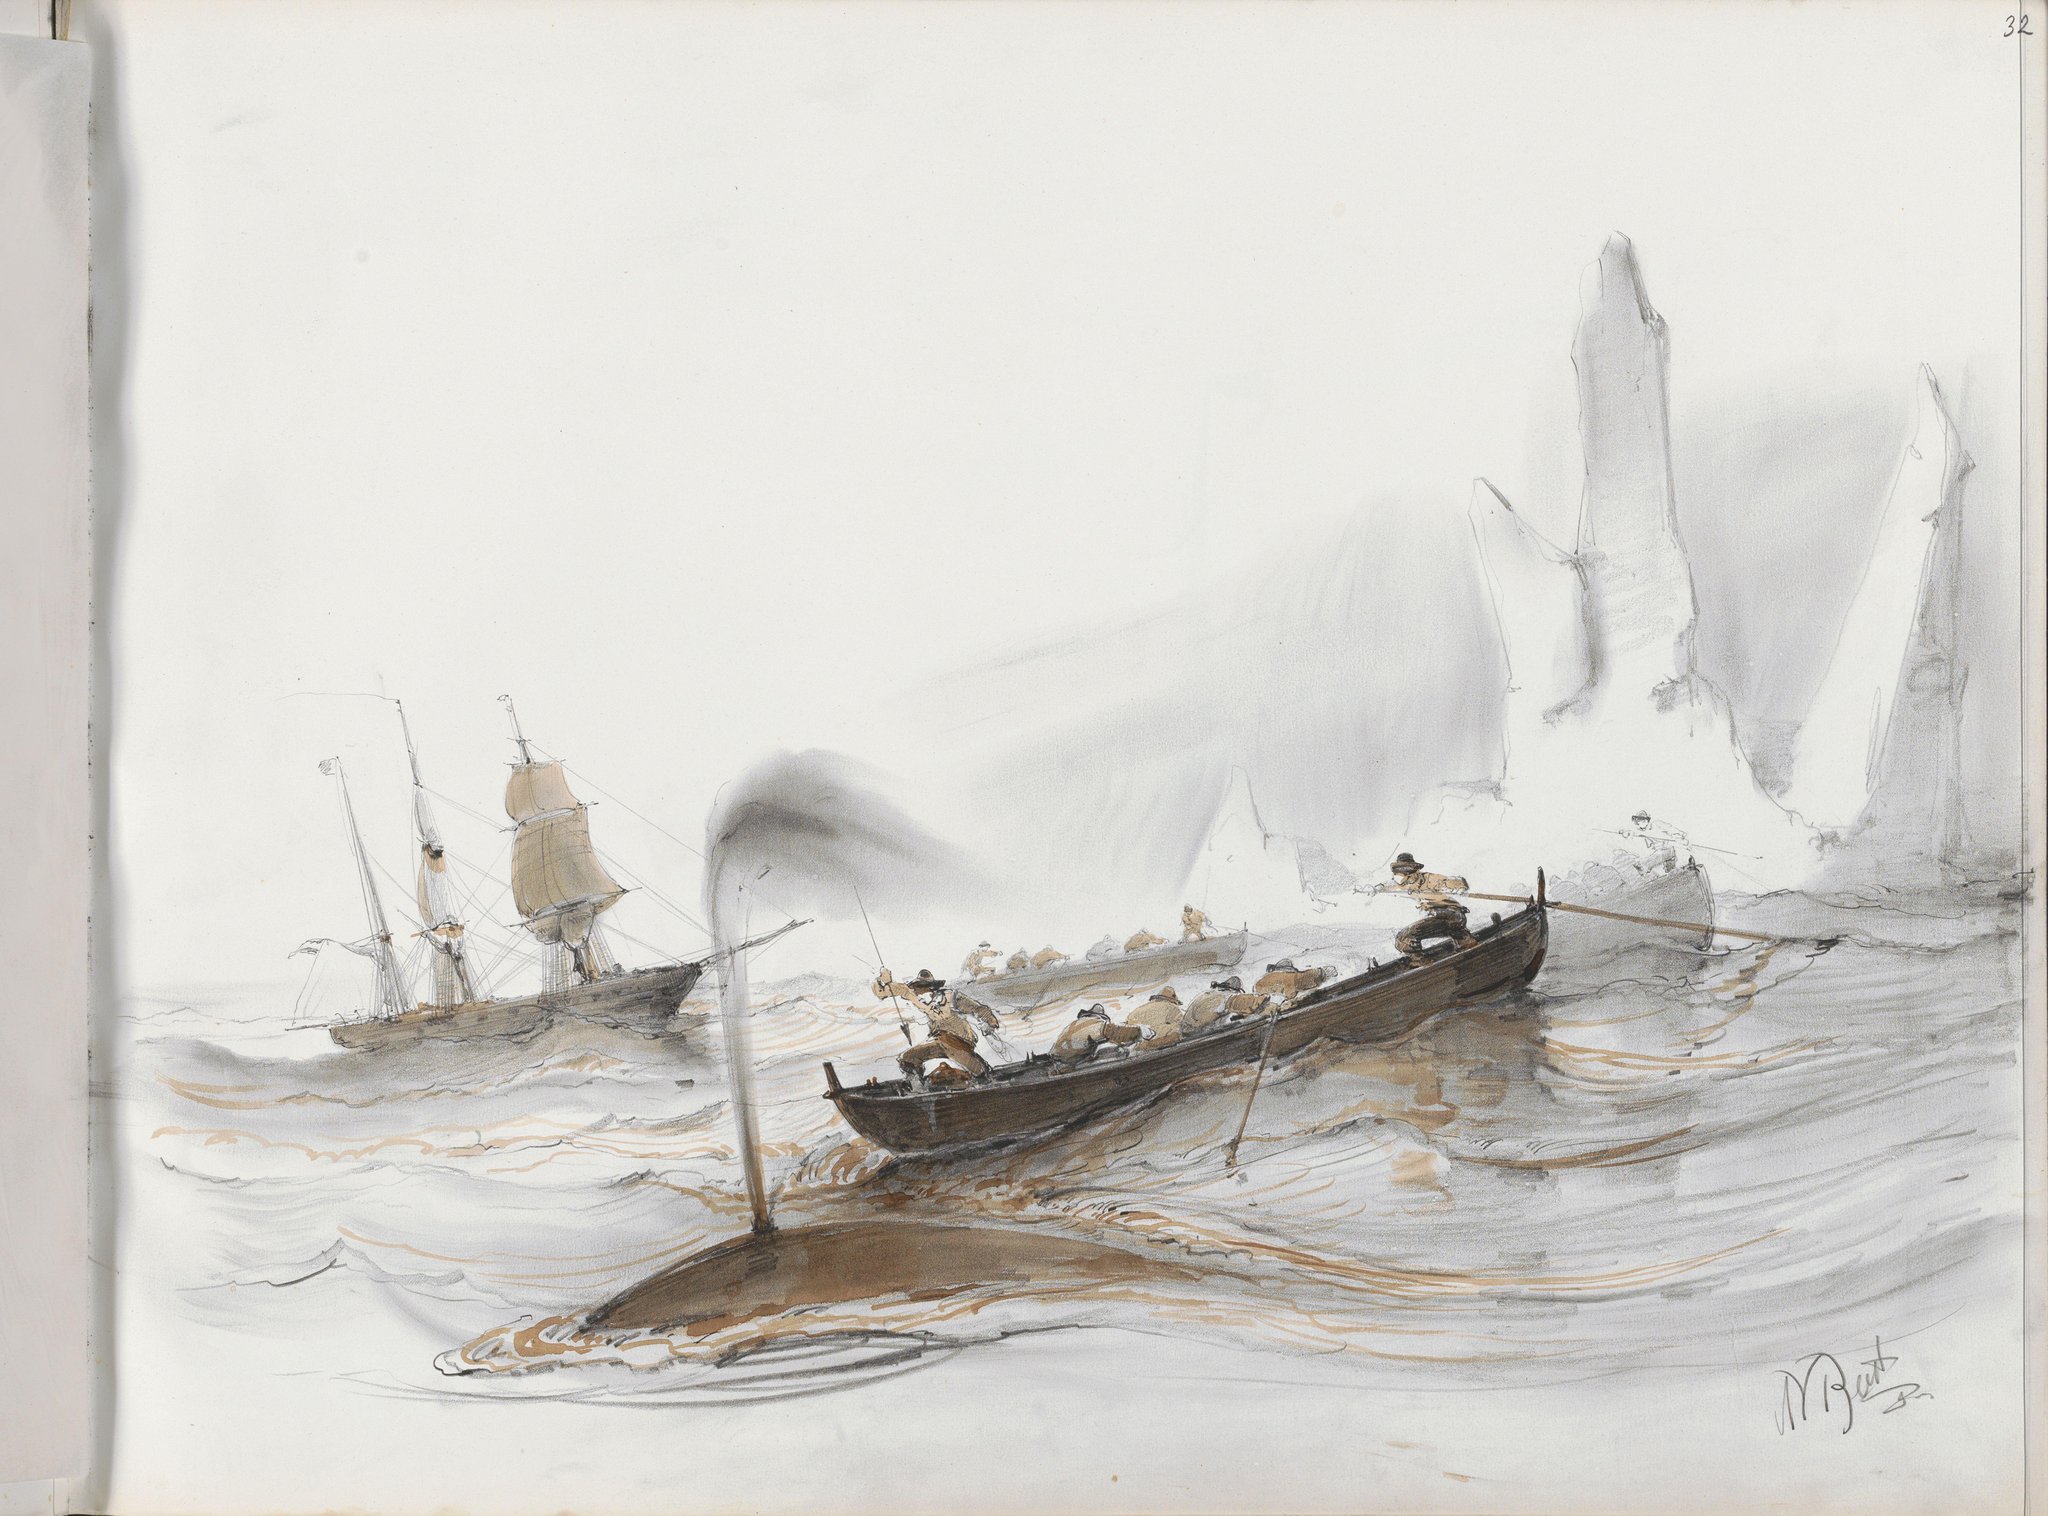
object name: sketchbook leaf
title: Walvisjagers bij een ijsschots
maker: albertus van beest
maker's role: draughtsman, print maker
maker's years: 1820-1860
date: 1830-1860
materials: paper, pencil, watercolor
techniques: brush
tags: whale fishery, whaling, drift ice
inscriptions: signature: ‘A V Beest’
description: Op de voorgrond een walvis die water spuit en jagers in roeiboten. Eén van hen houdt een harpoen in de aanslag. Op de achtergrond een driemaster en ijsschotsen. Blad 32 recto uit een schetsboek met 46 bladen.